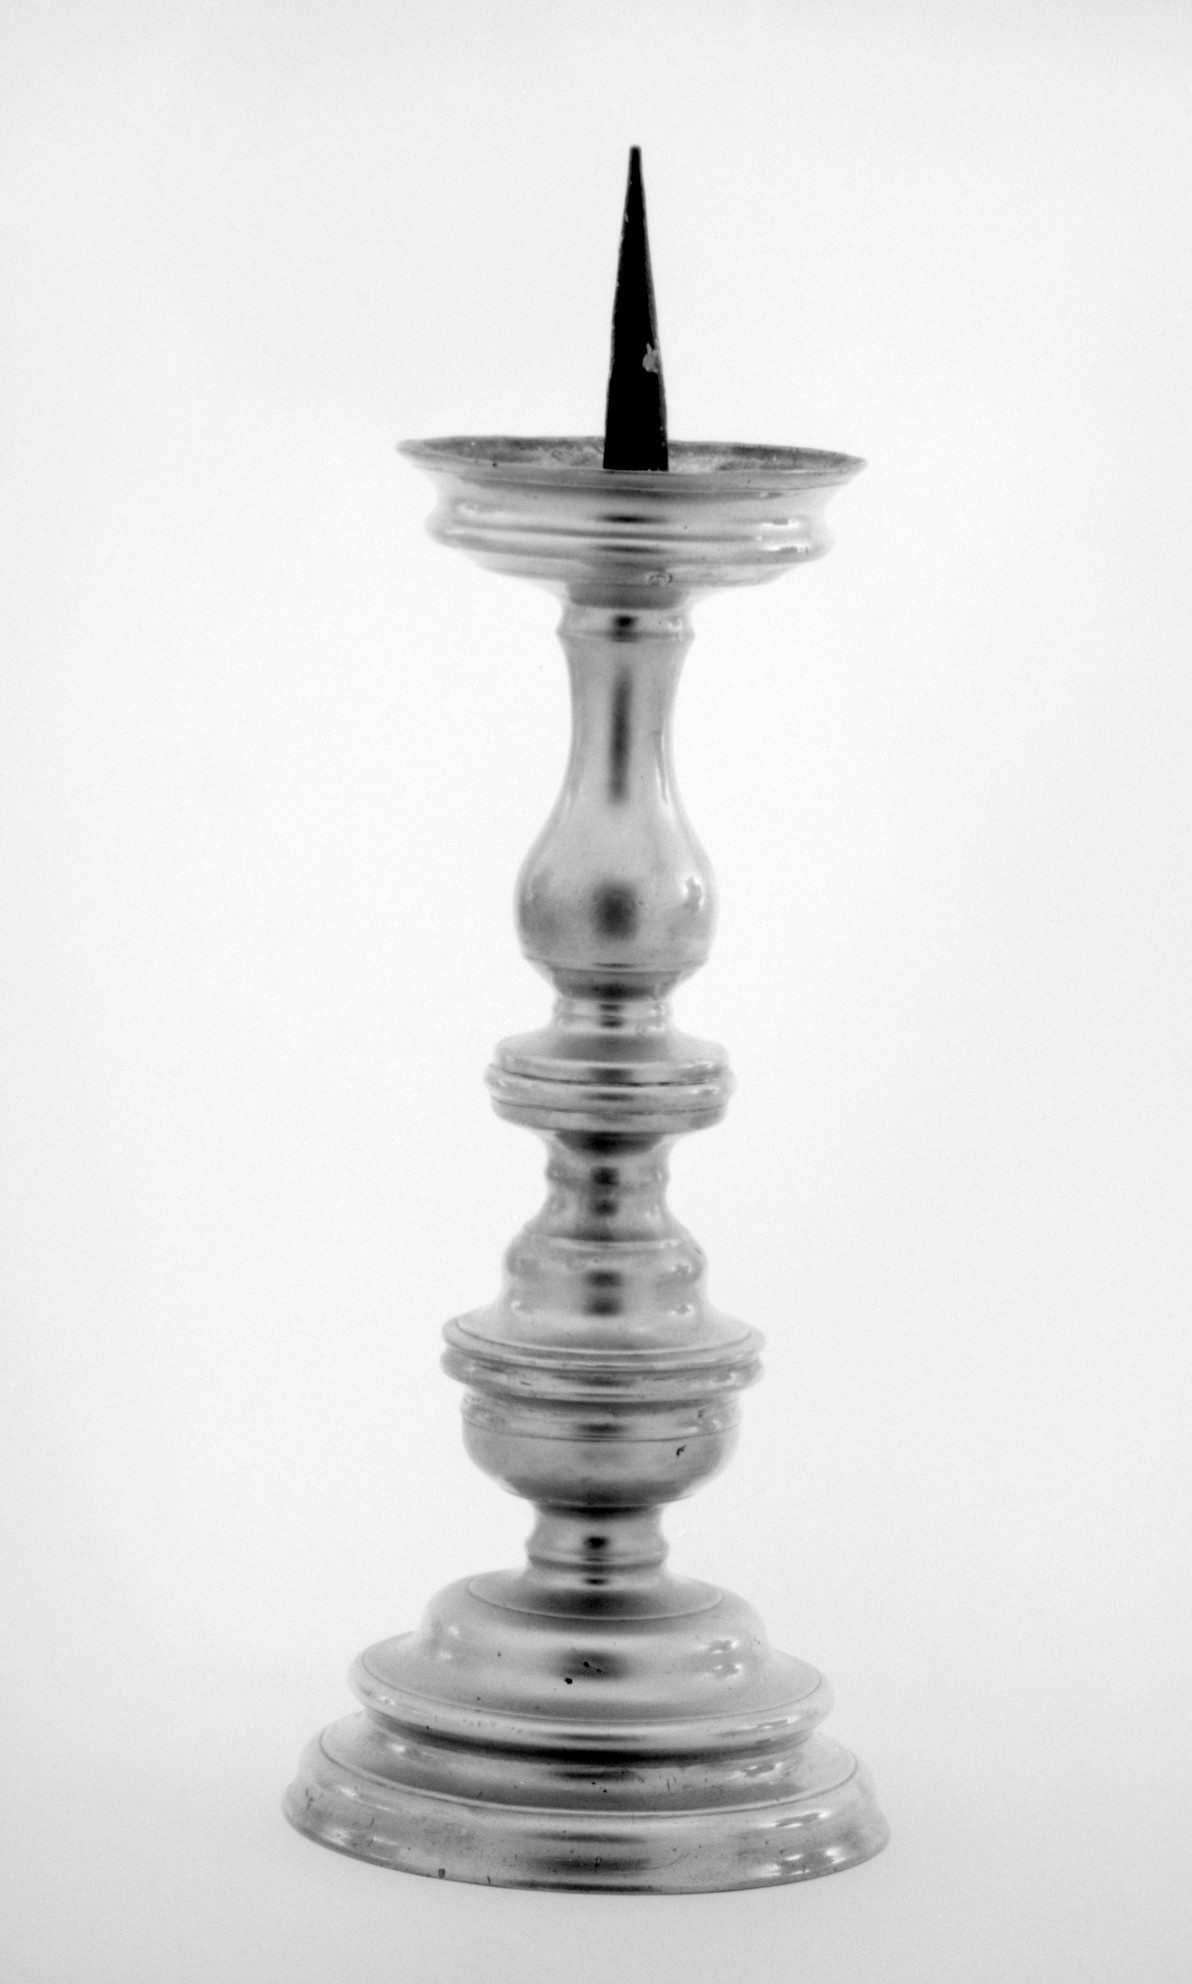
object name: candlestick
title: Pair of candlesticks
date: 1667-1700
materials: brass, iron